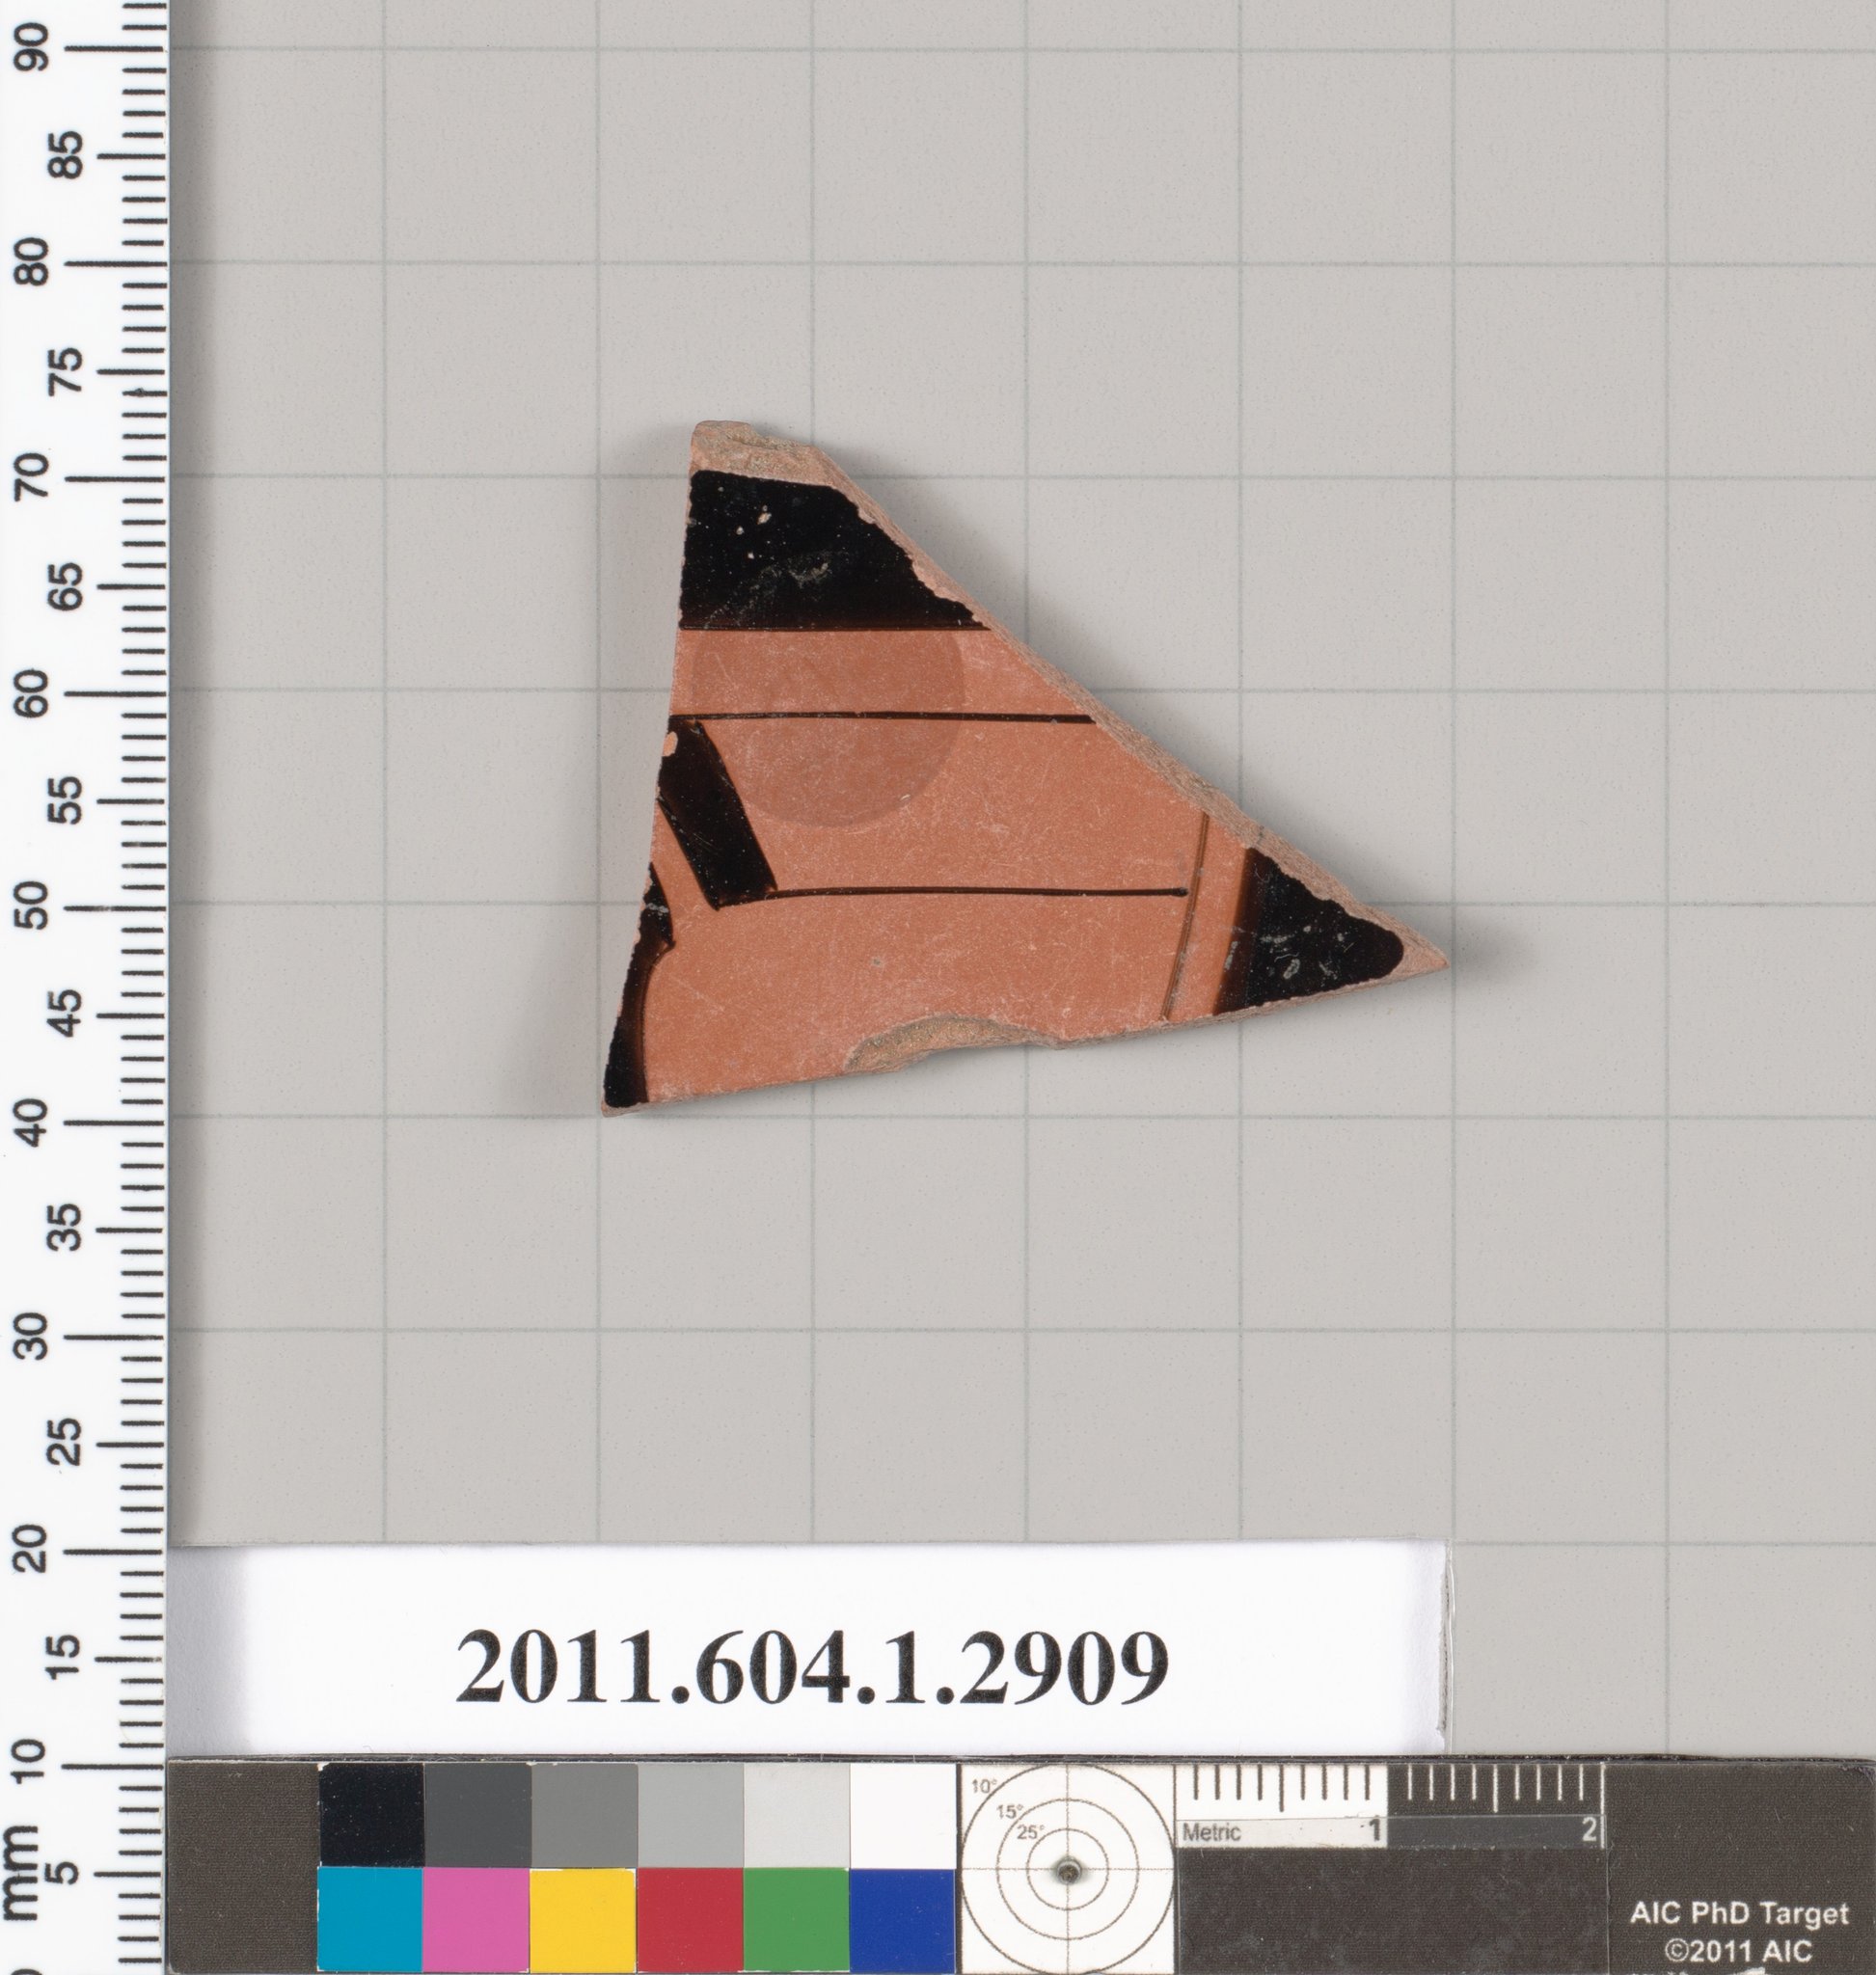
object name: kylix fragment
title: Terracotta fragment of a kylix (drinking cup)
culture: greek, attic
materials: terracotta